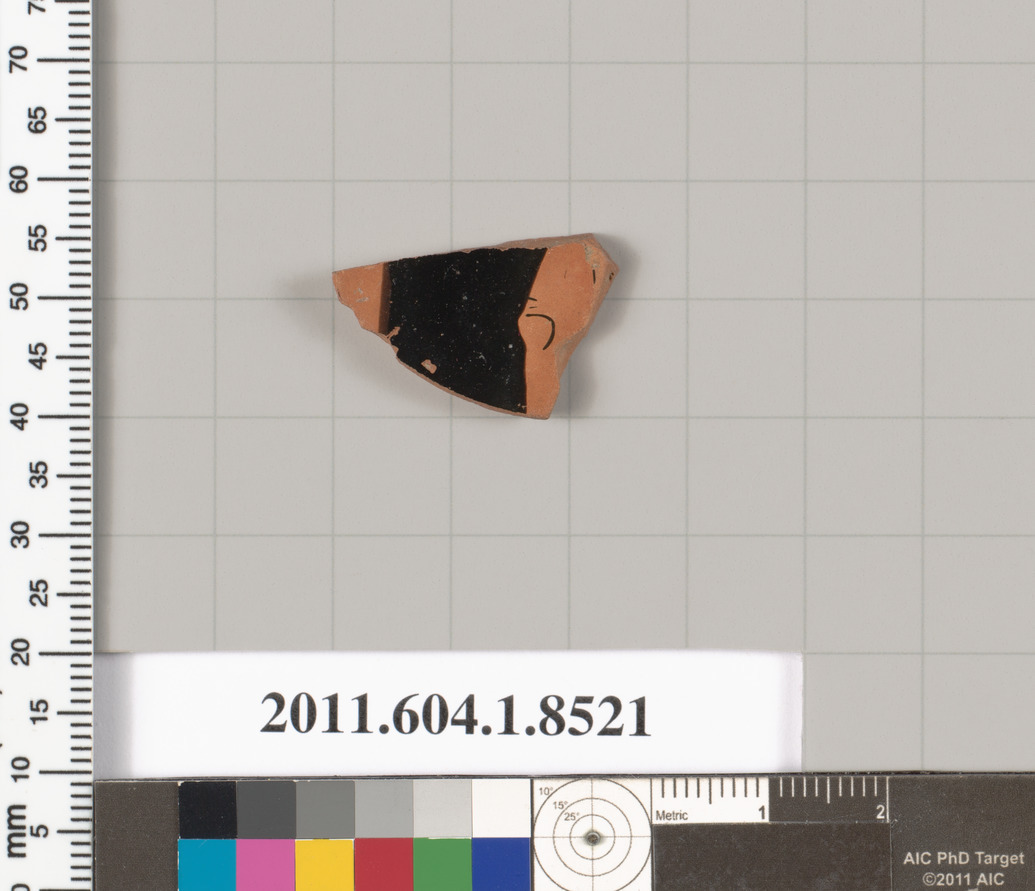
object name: kylix fragment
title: Terracotta fragment of a stemless kylix (drinking cup)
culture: greek, attic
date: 460-450 BCE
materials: terracotta